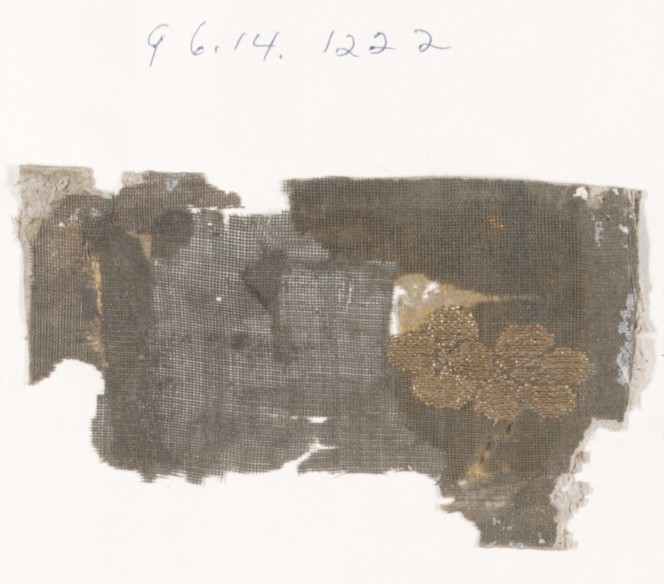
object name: piece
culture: china or japan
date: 1101-1400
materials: silk